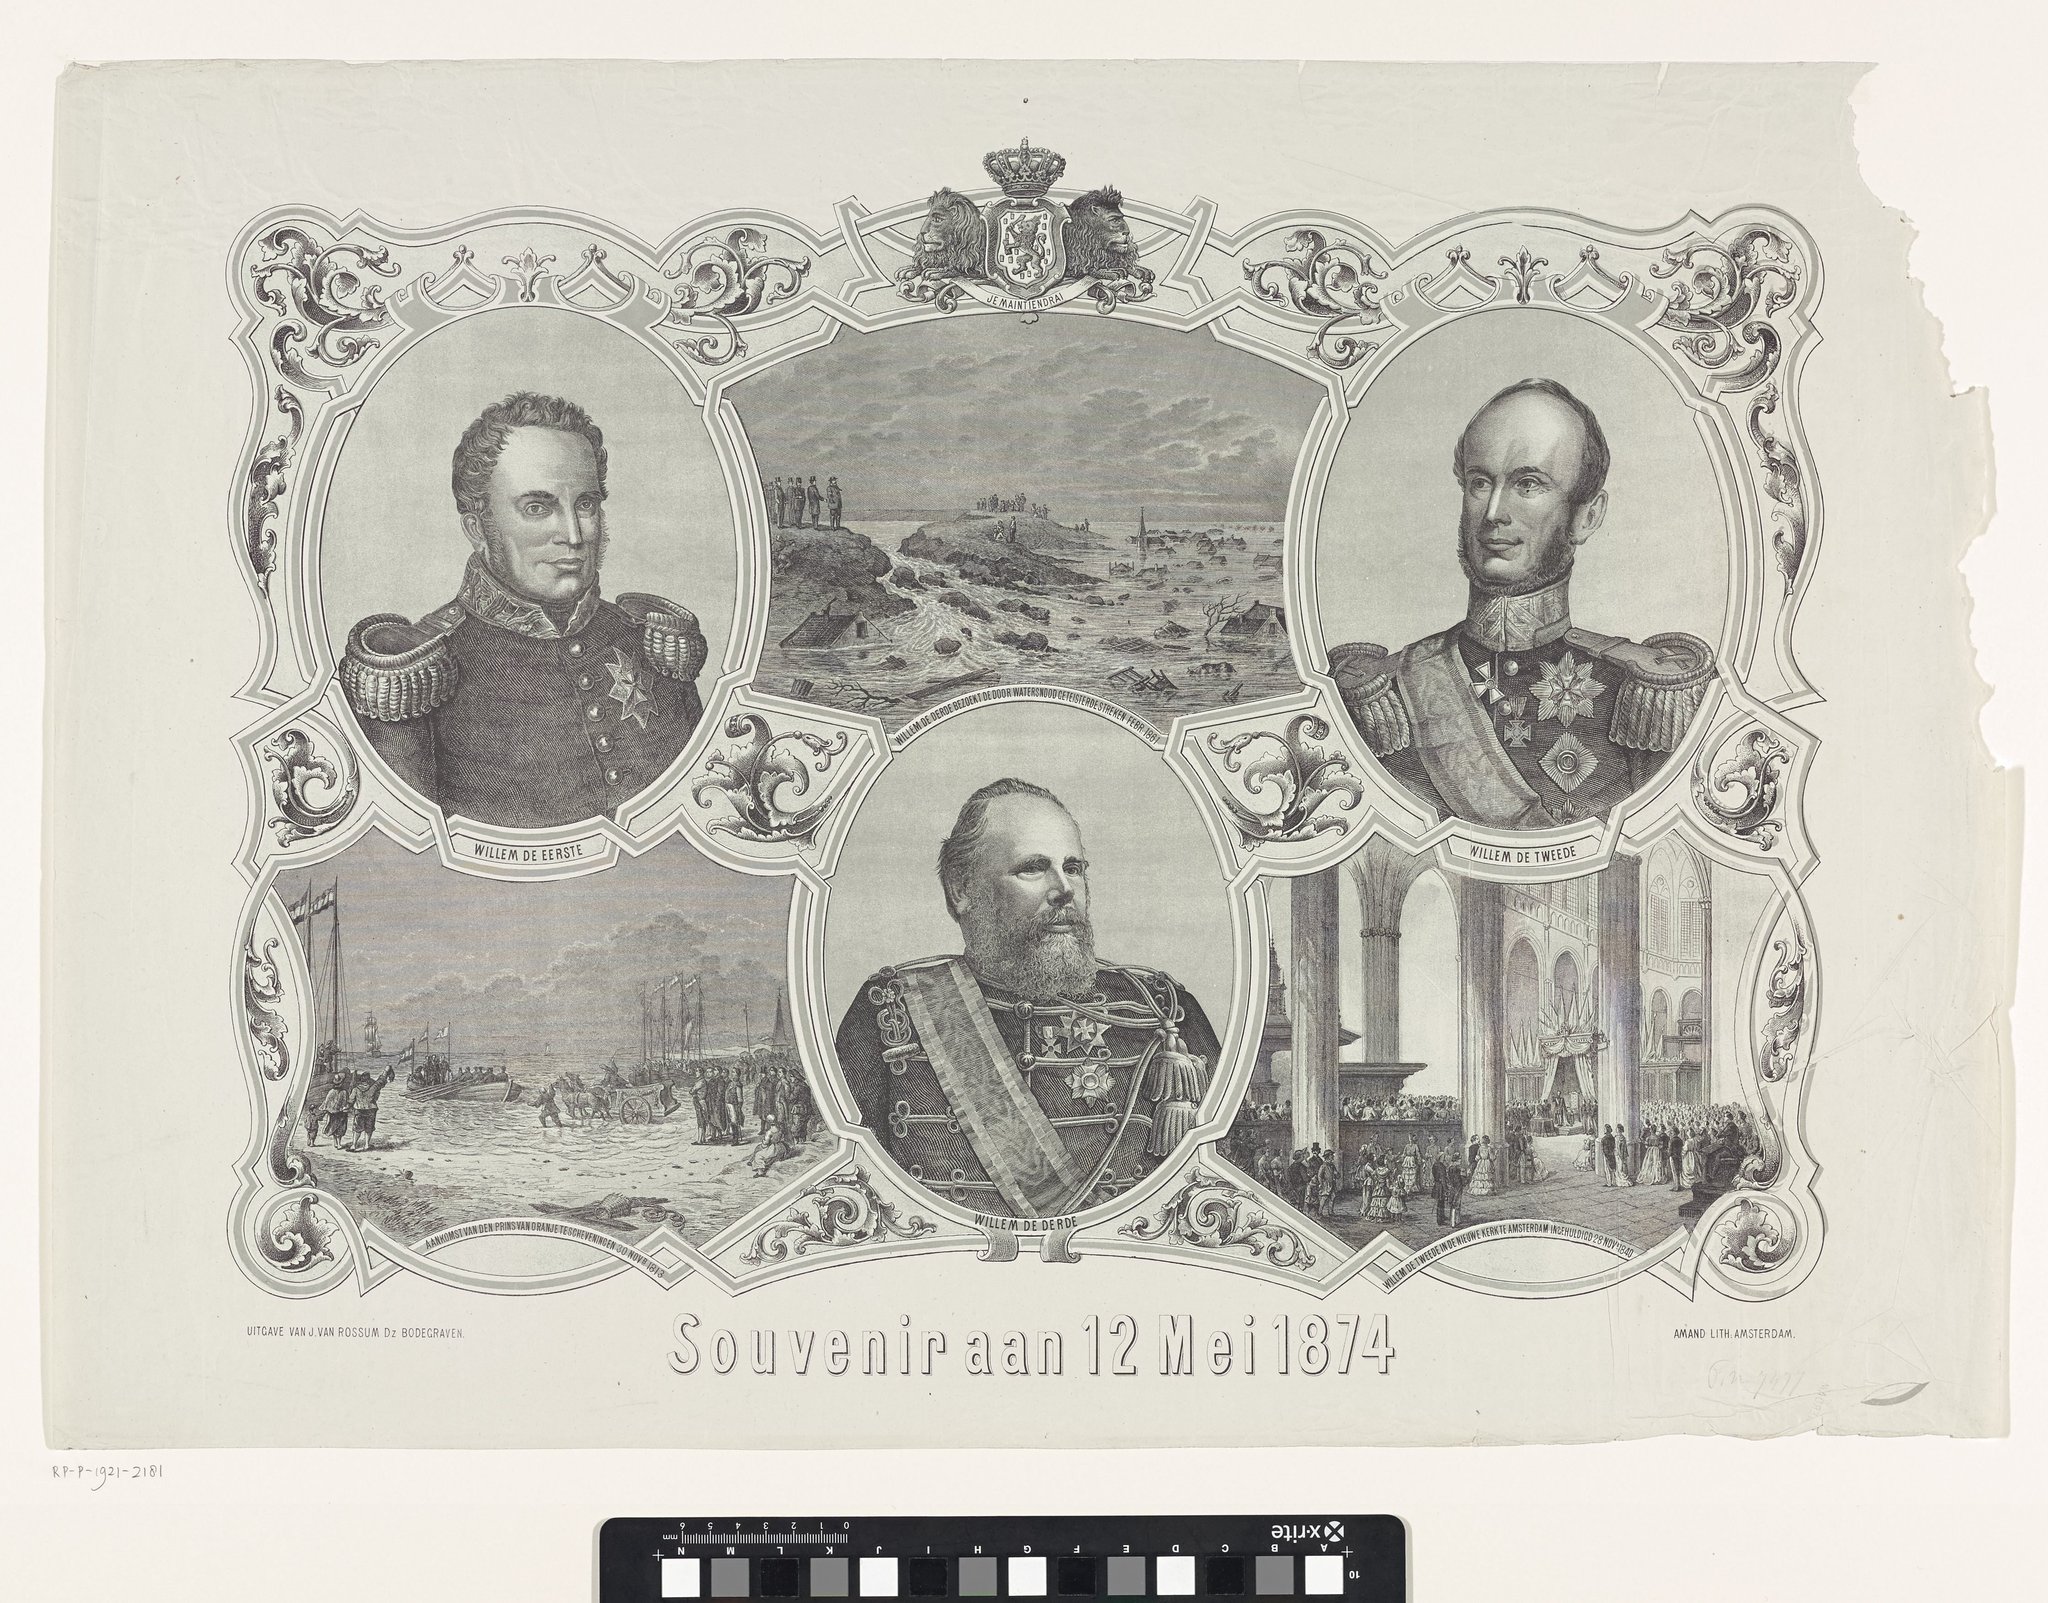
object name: print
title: Souvenir aan 12 Mei 1874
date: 1874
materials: paper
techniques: tone lithography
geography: netherlands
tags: the hague, william i of the netherlands, brussels, willem iii (koning der nederlanden), william ii of the netherlands, historical persons, landing of william frederick i (1813)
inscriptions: collector's mark: Lugt 2233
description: Gedenkplaat bij de viering van het 25-jarige regeringsjubileum van koning Willem III, 12 mei 1874. Portretten van de drie koningen Willem I, II en III. Met drie scènes van de aankomst van Willem I te Scheveningen (1813), de inhuldiging van Willem II (1840) en het bezoek van Willem III aan de door watersnood geteisterde streken (1861).